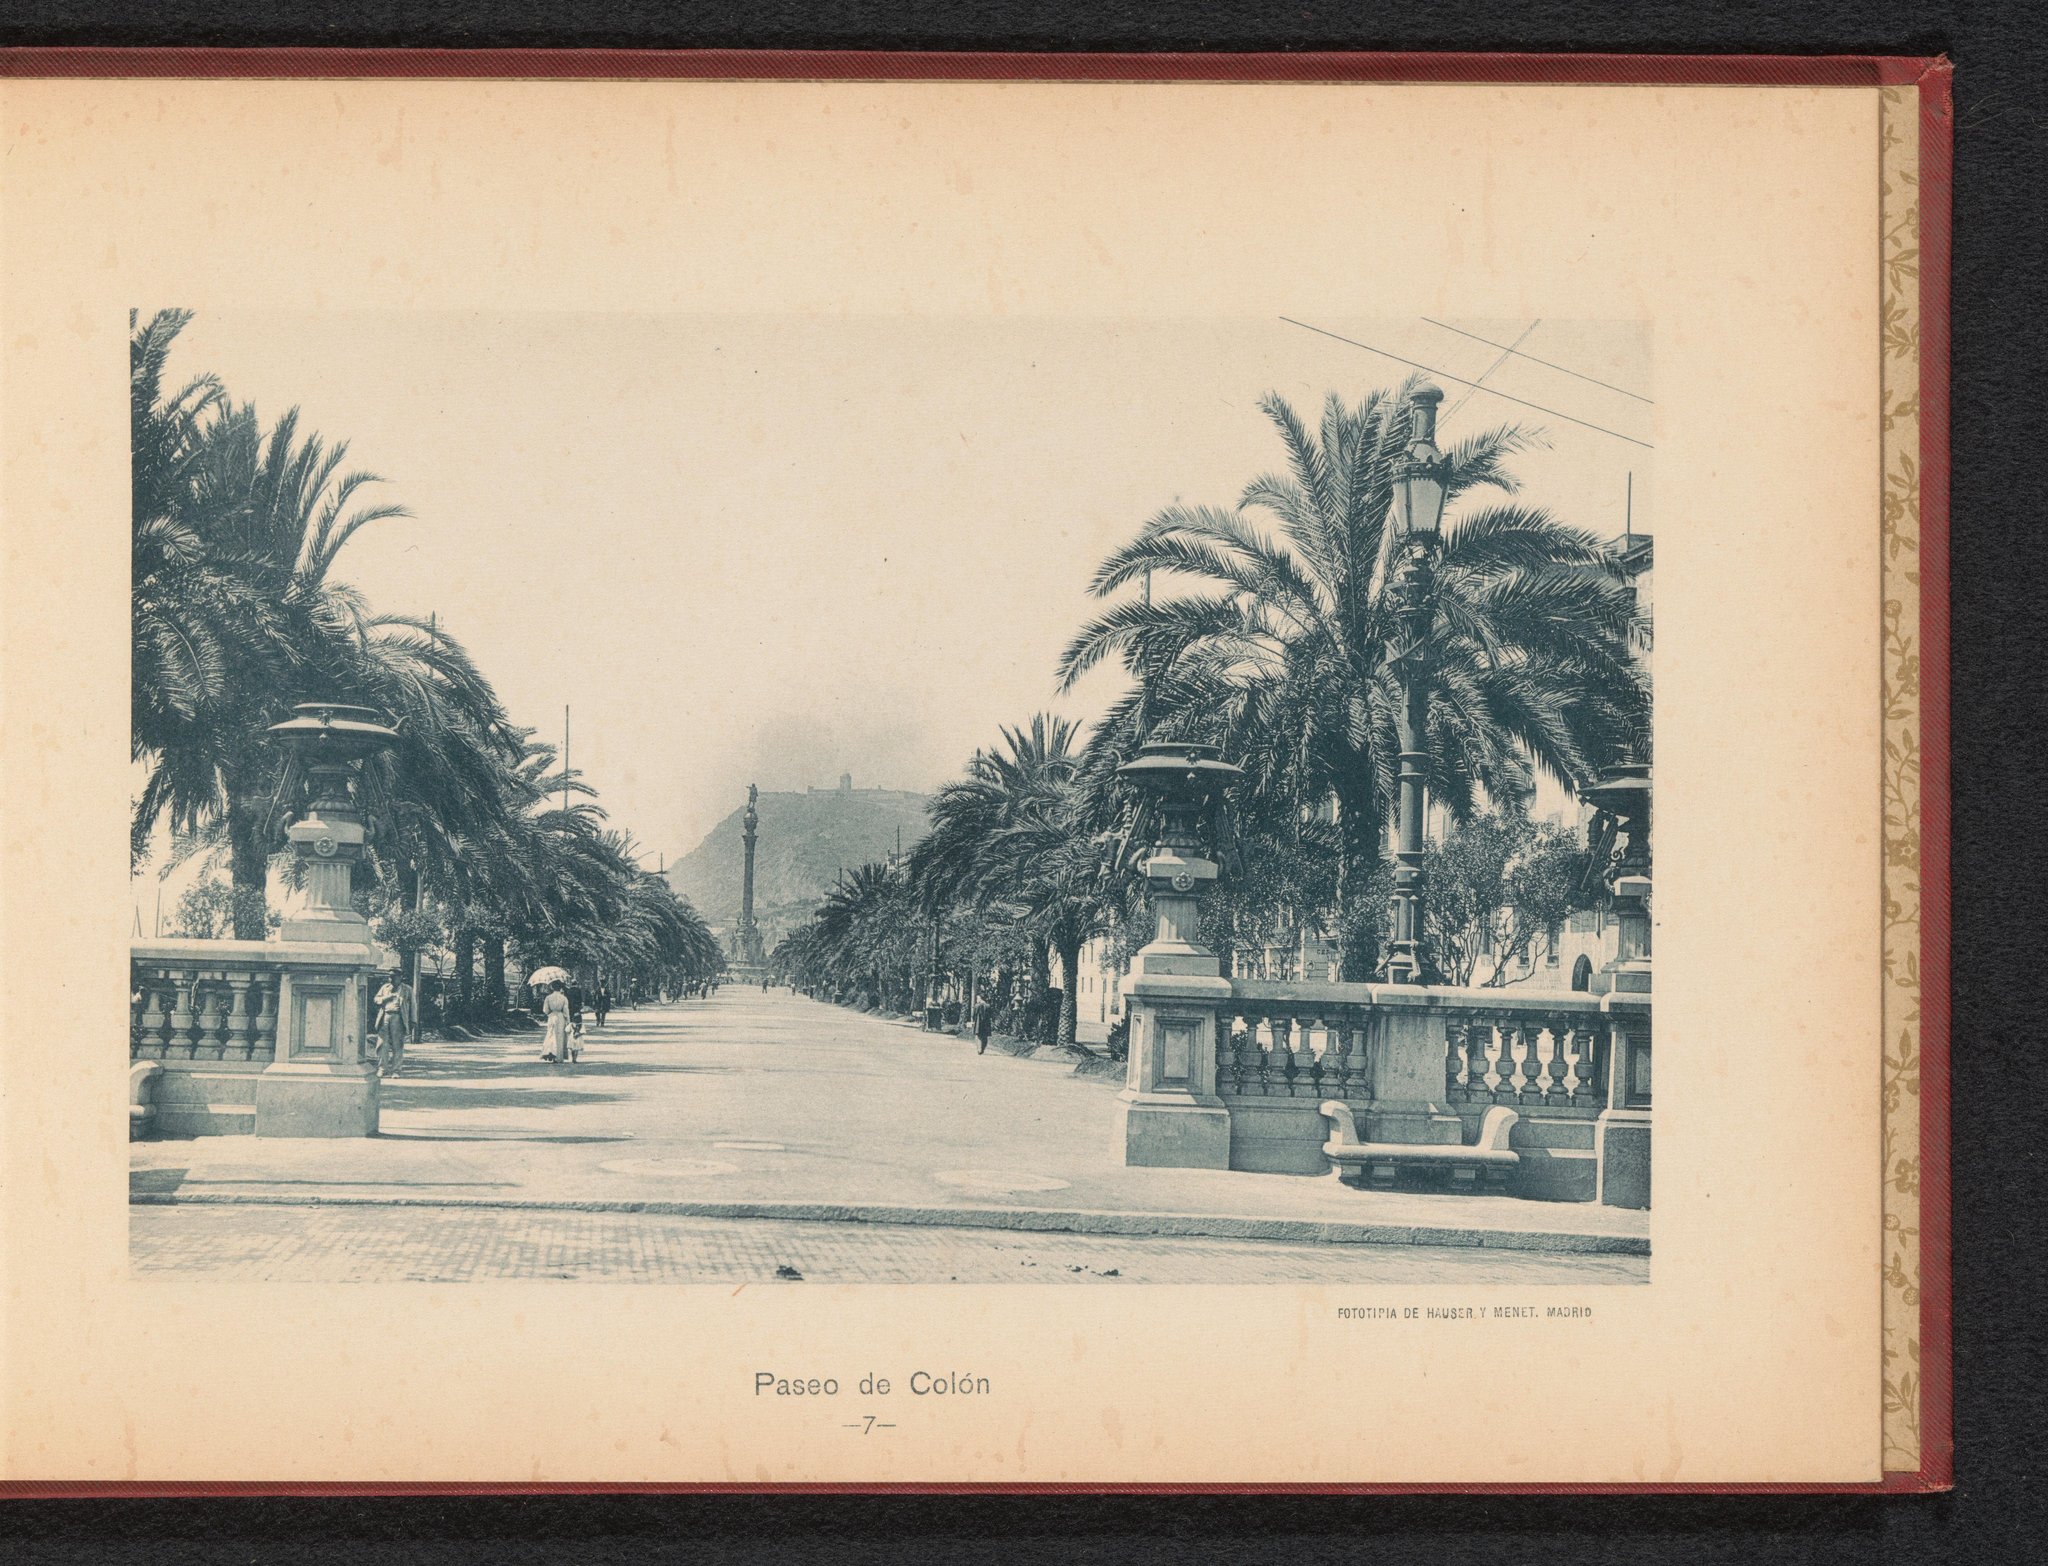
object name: photomechanical print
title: Paseo de Colón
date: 1880-1890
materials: paper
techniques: photograph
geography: barcelona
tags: avenue, boulevard in village (+ city(-scape) with figures, staffage), monument, statue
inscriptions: number: ‘-7-’